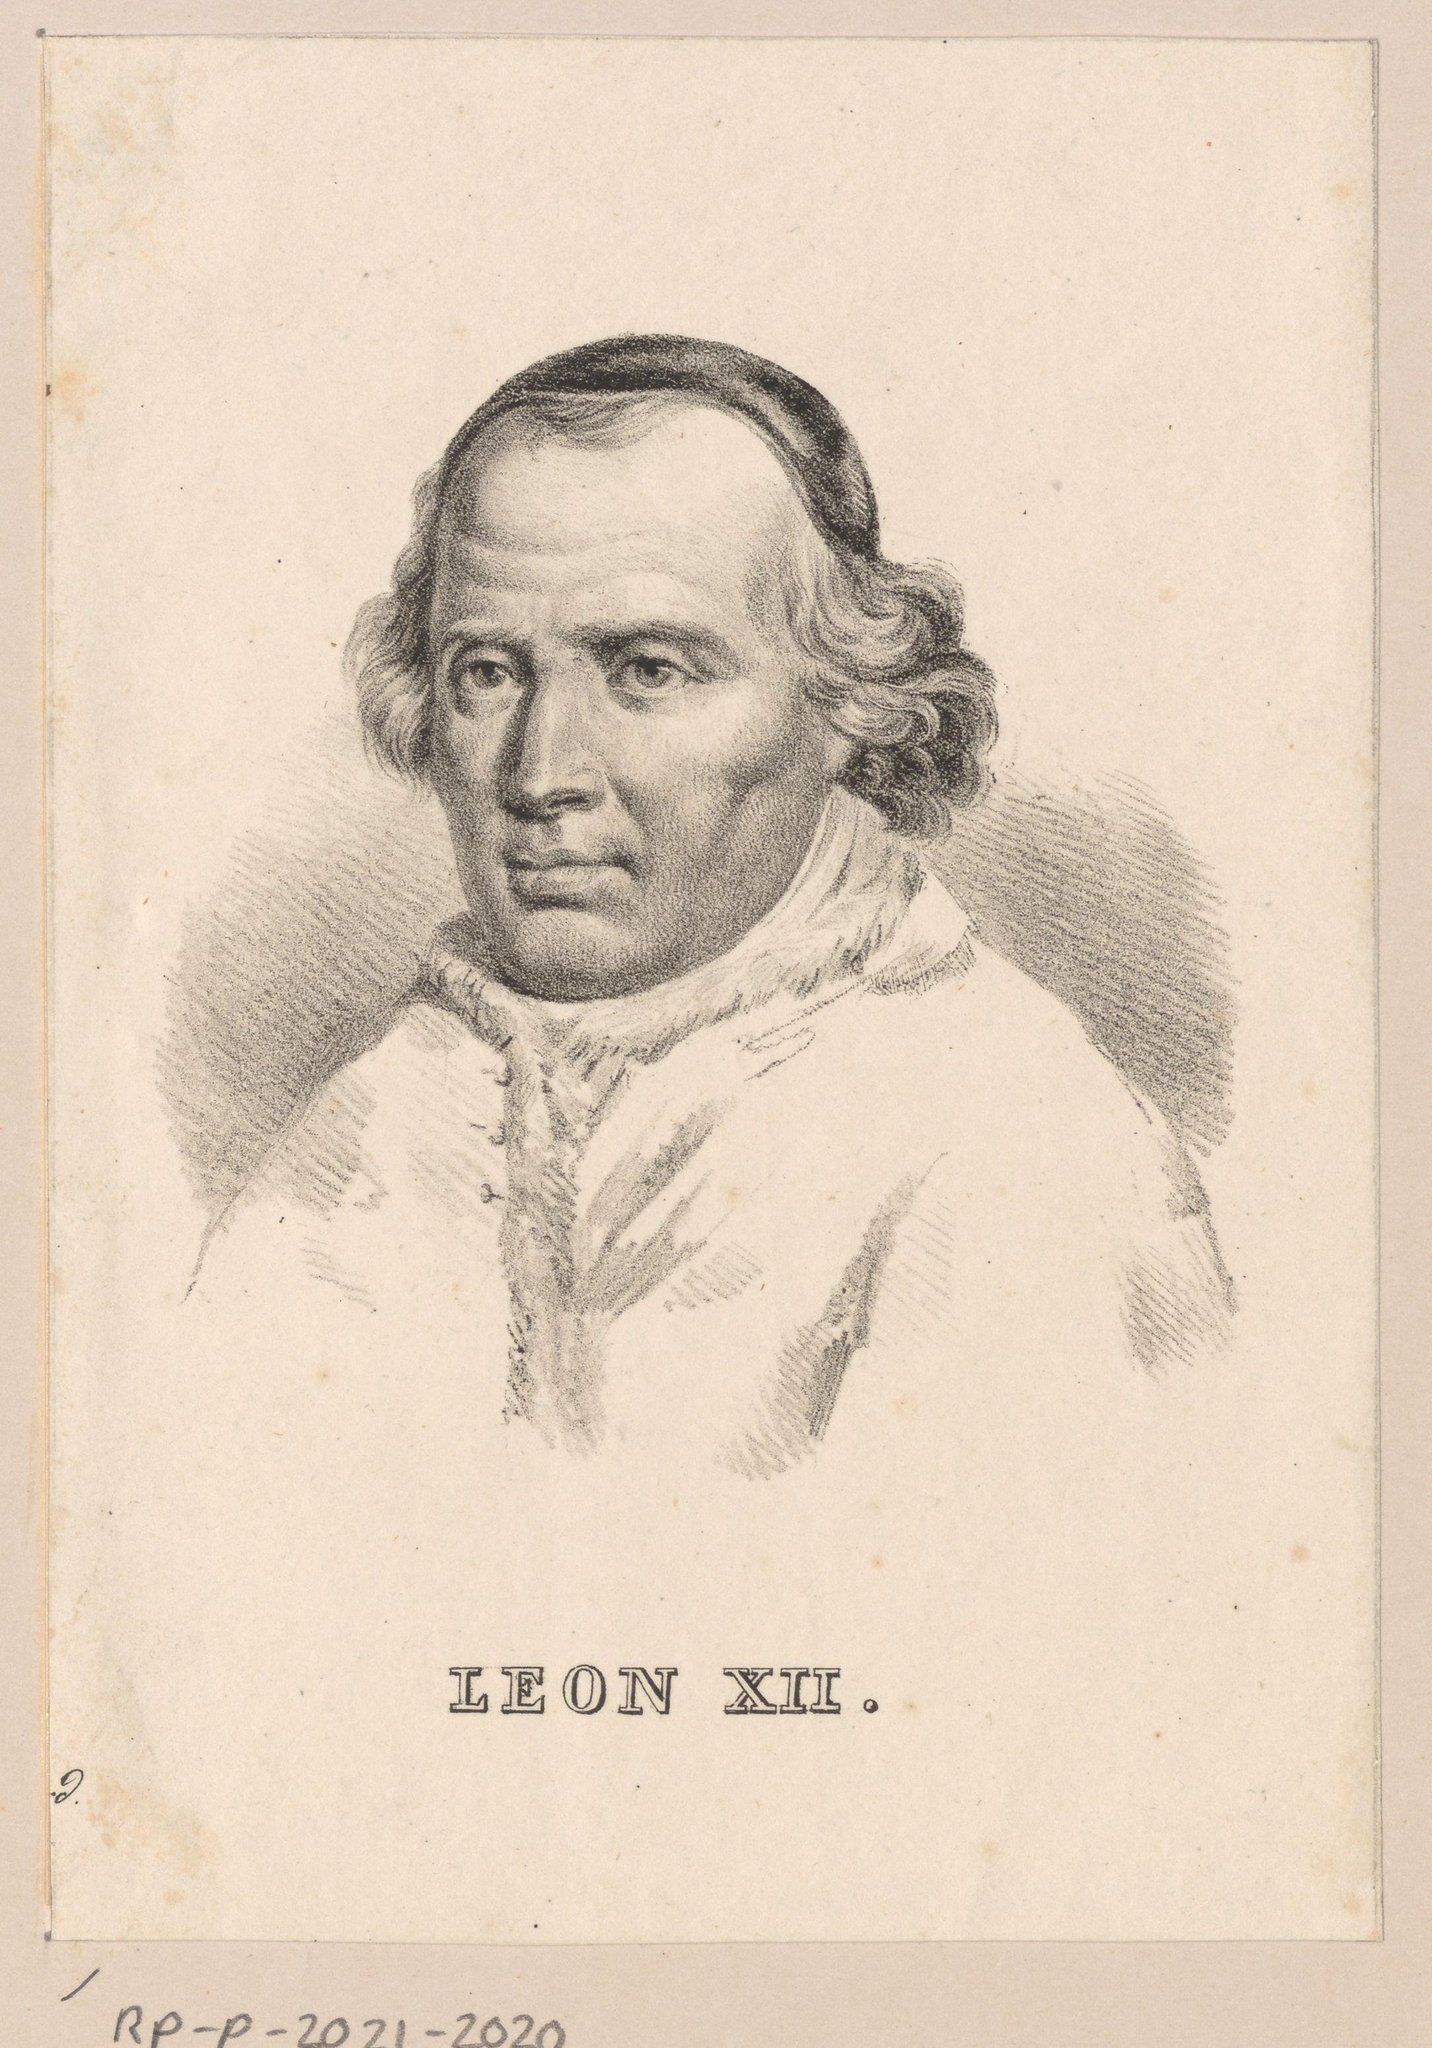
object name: print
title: Portret van paus Leo XII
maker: Anonymous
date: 1823-1899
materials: paper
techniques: lithograph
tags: rome, historical persons, pope